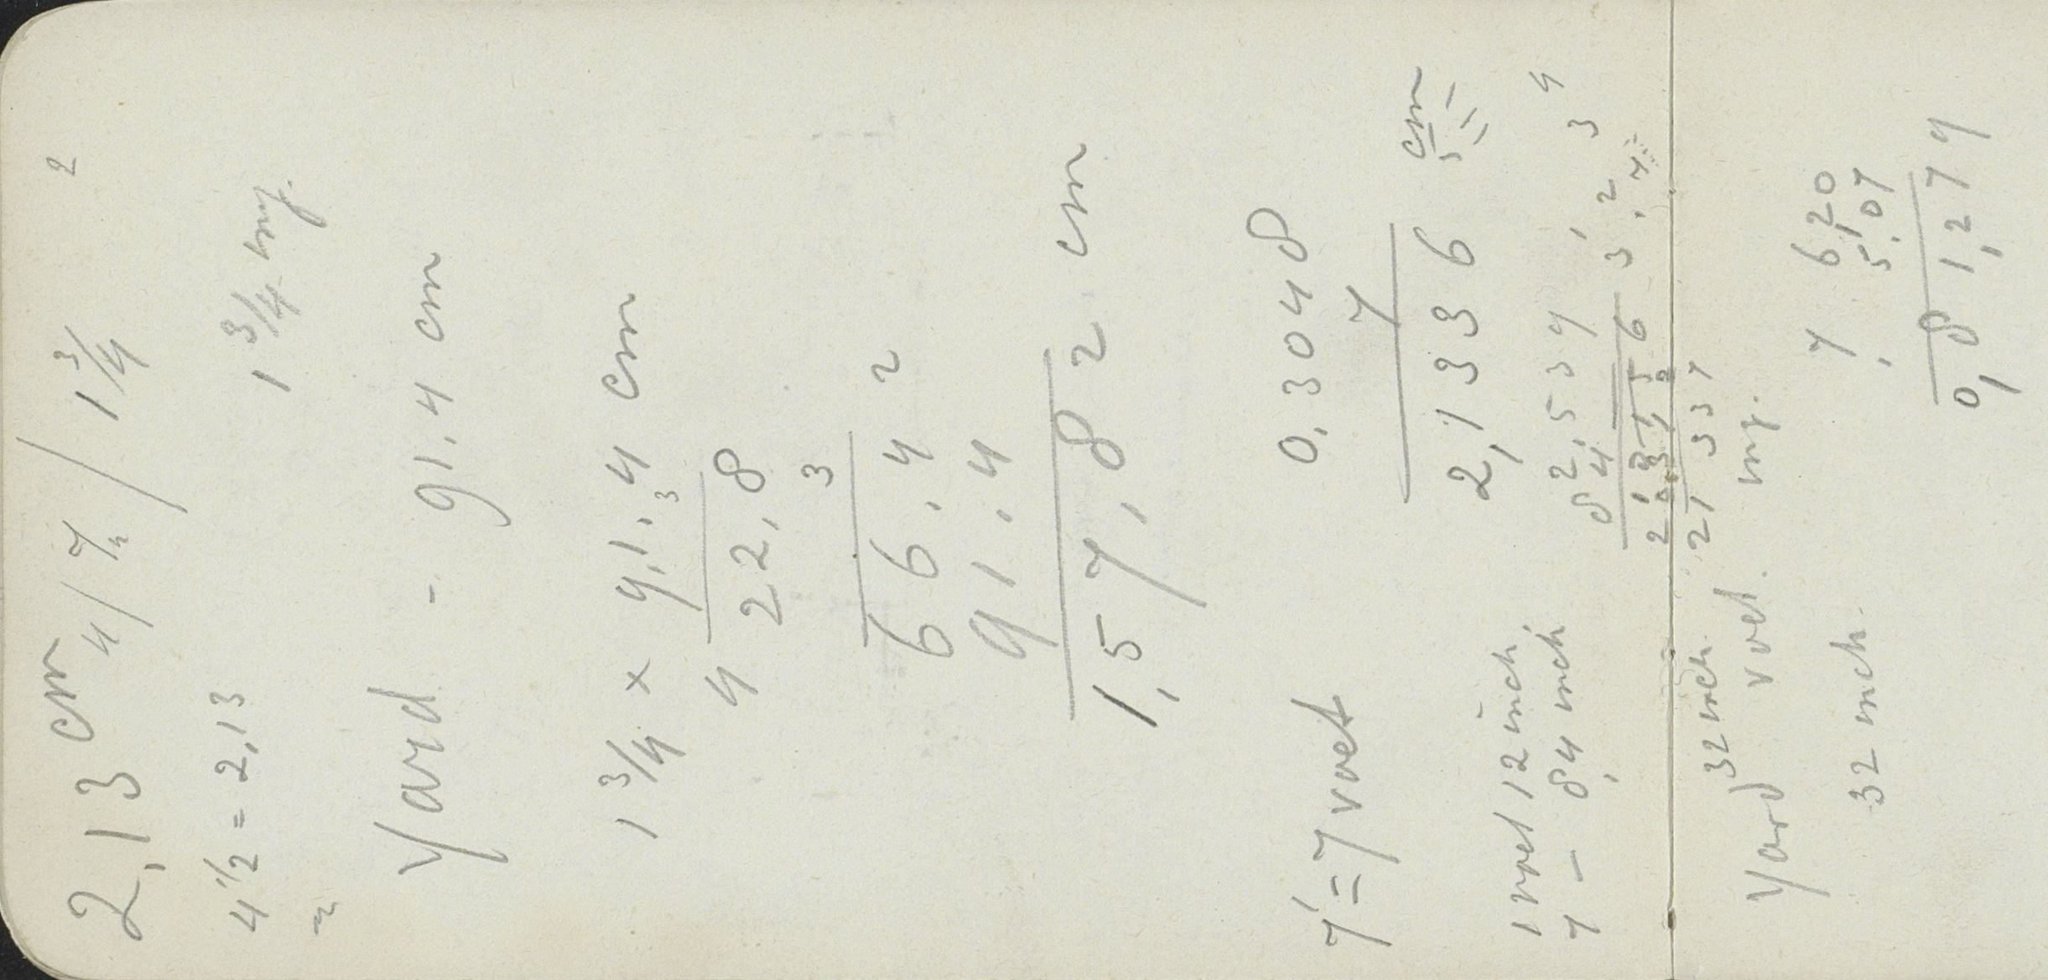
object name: sketchbook leaf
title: Berekeningen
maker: carel adolph lion cachet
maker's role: draughtsman, print maker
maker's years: 1864-1945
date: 1905-1906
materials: paper, pencil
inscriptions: annotation: ‘[...]’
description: Blad 3 verso uit een schetsboek met 34 bladen.